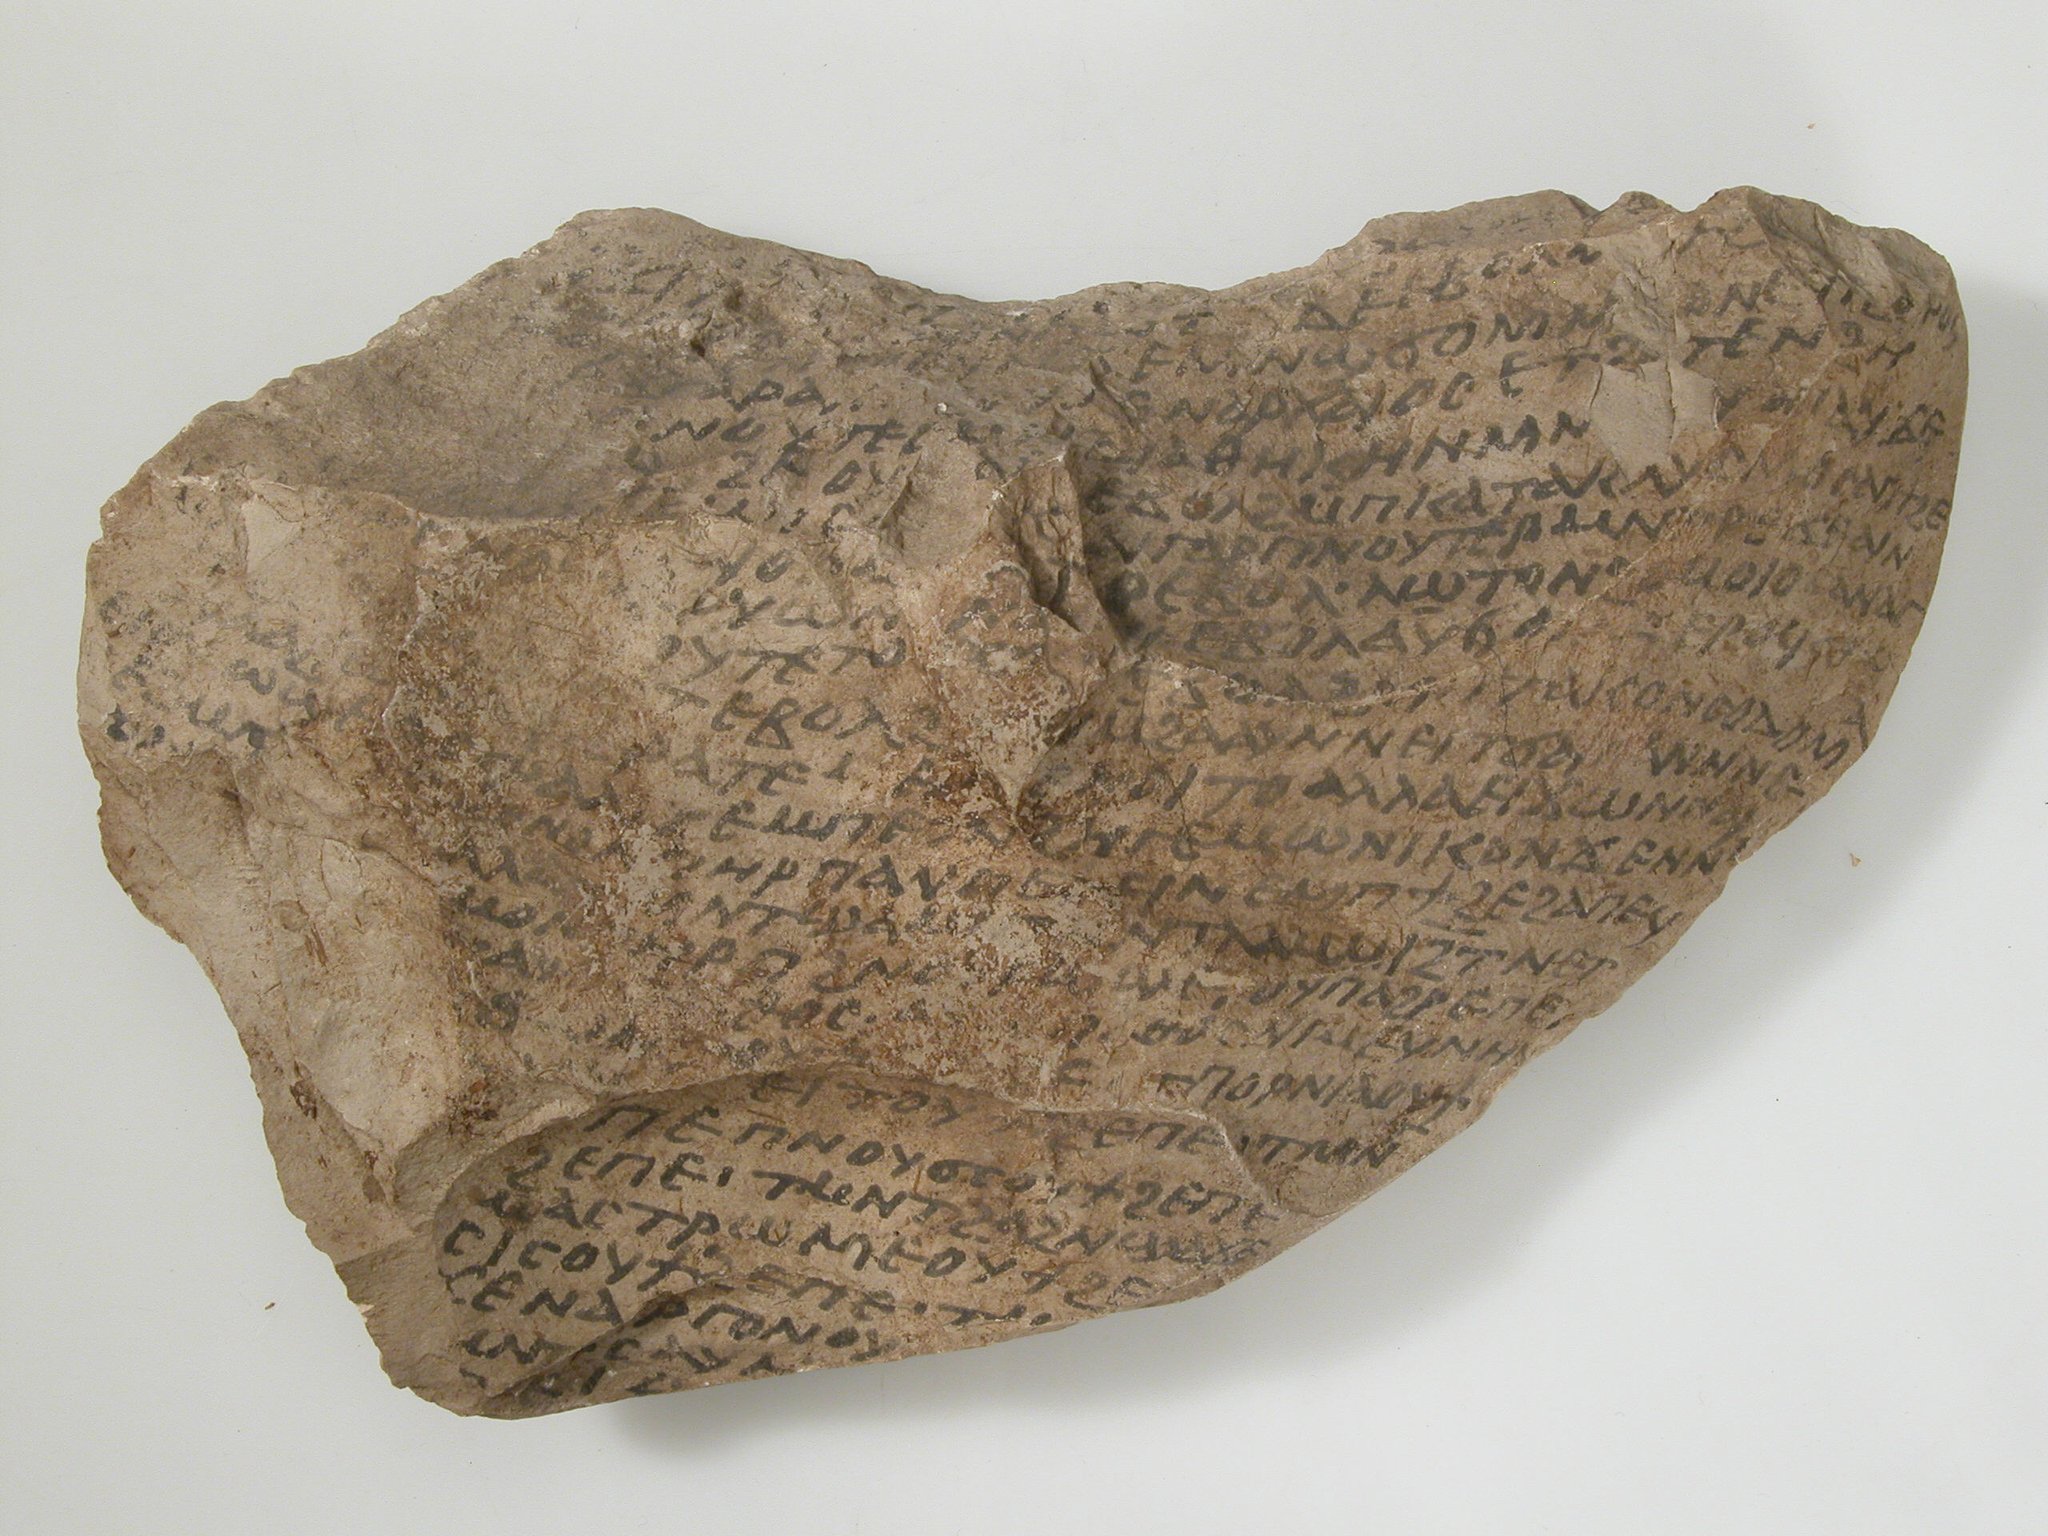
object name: ostrakon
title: Ostrakon with a Homily by Athanasius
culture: coptic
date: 600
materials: ink, limestone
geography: egypt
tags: coptic,documents